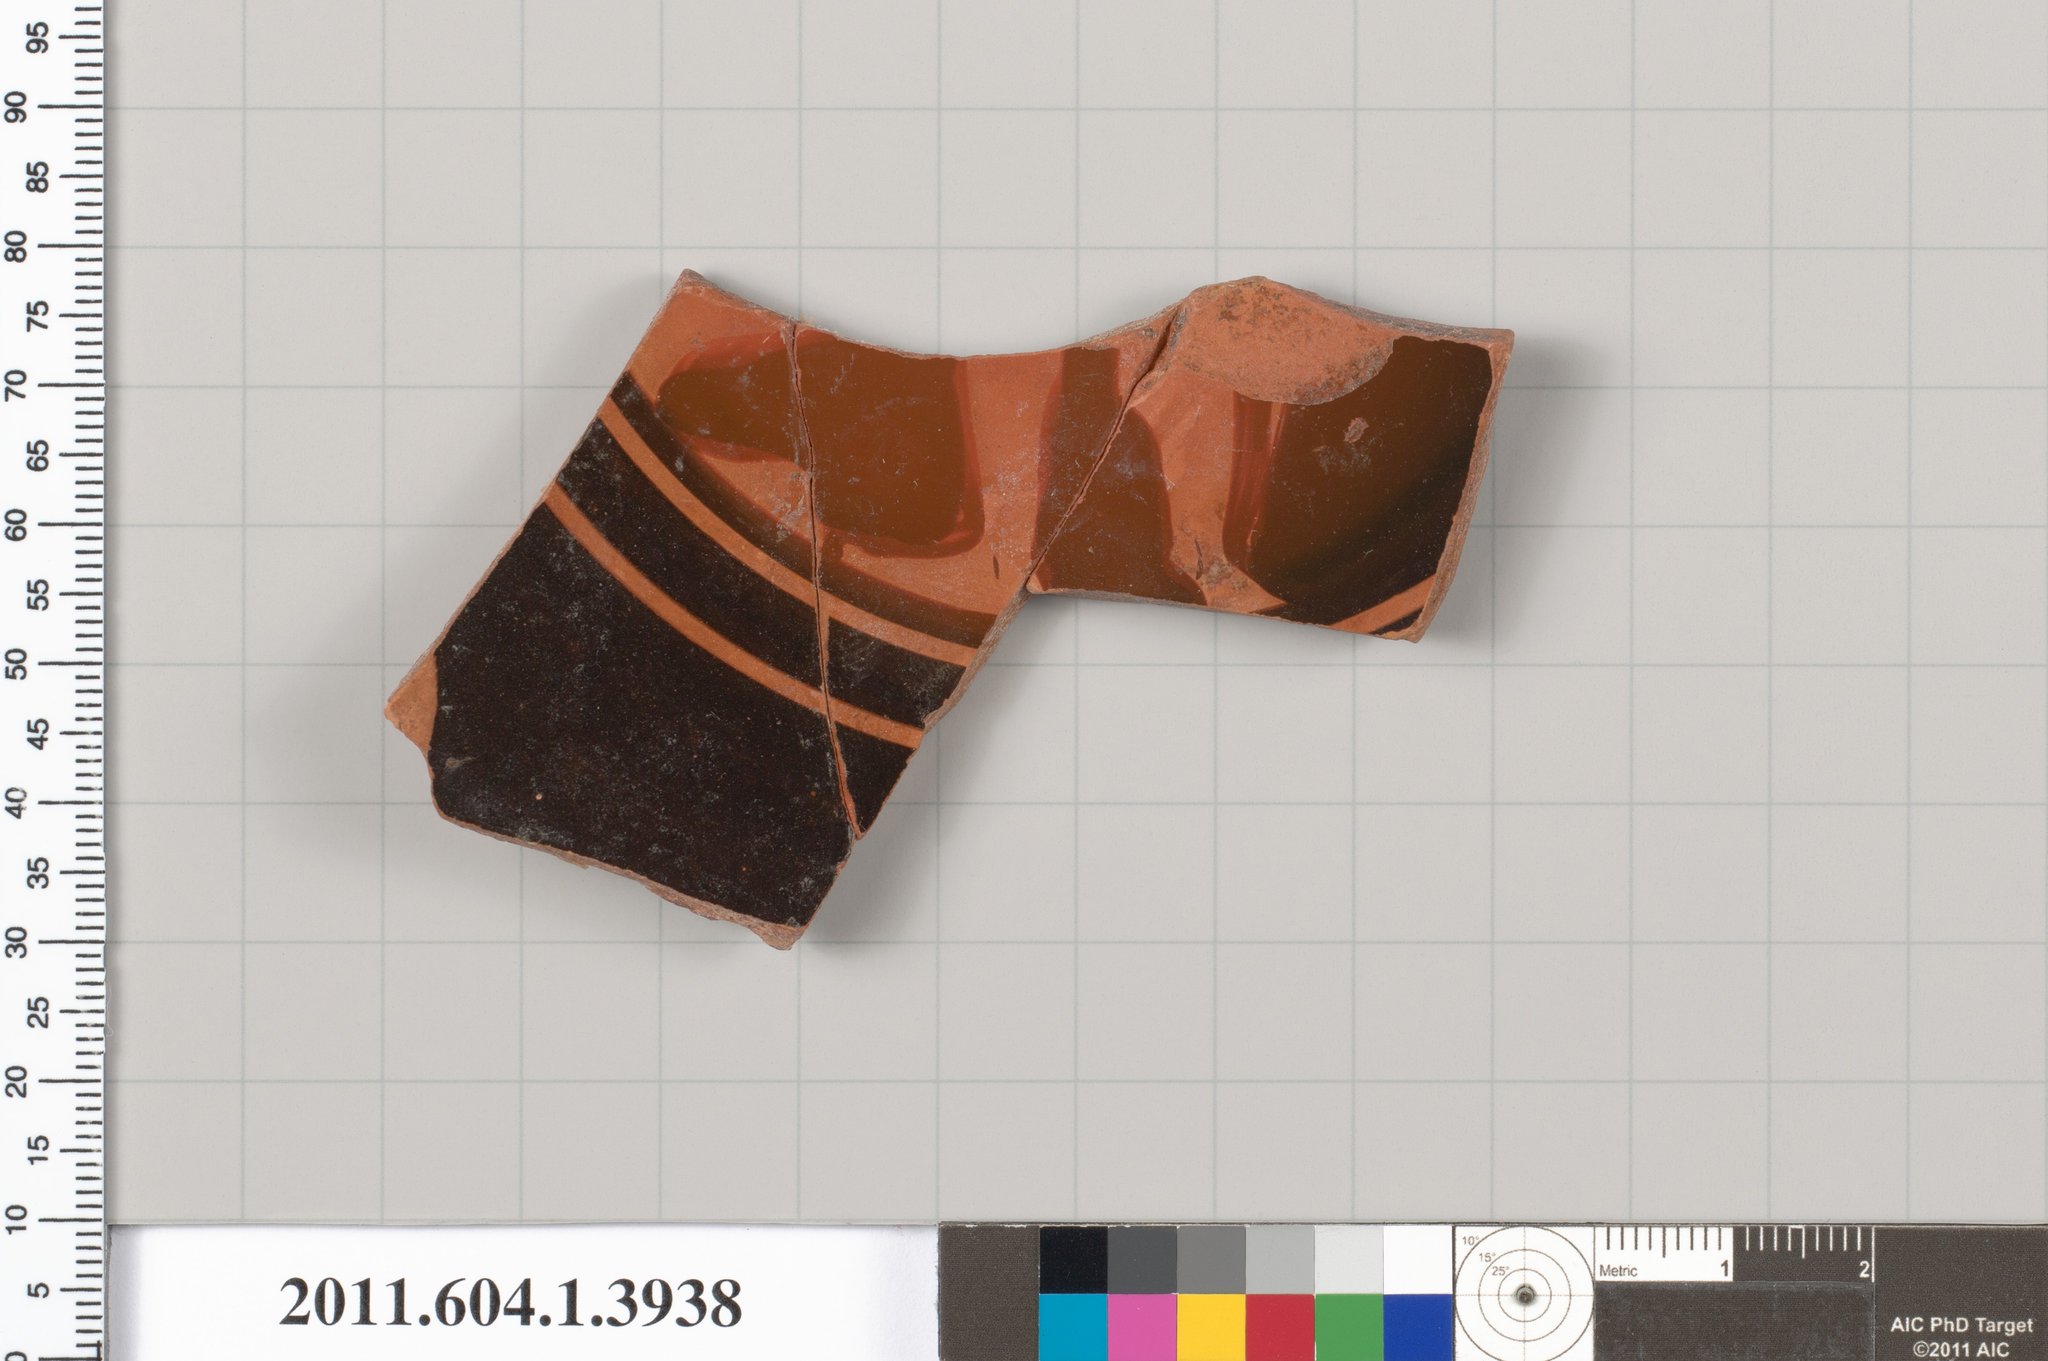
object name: kylix fragment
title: Terracotta fragment of a kylix (drinking cup)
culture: greek, attic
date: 500-470 BCE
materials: terracotta